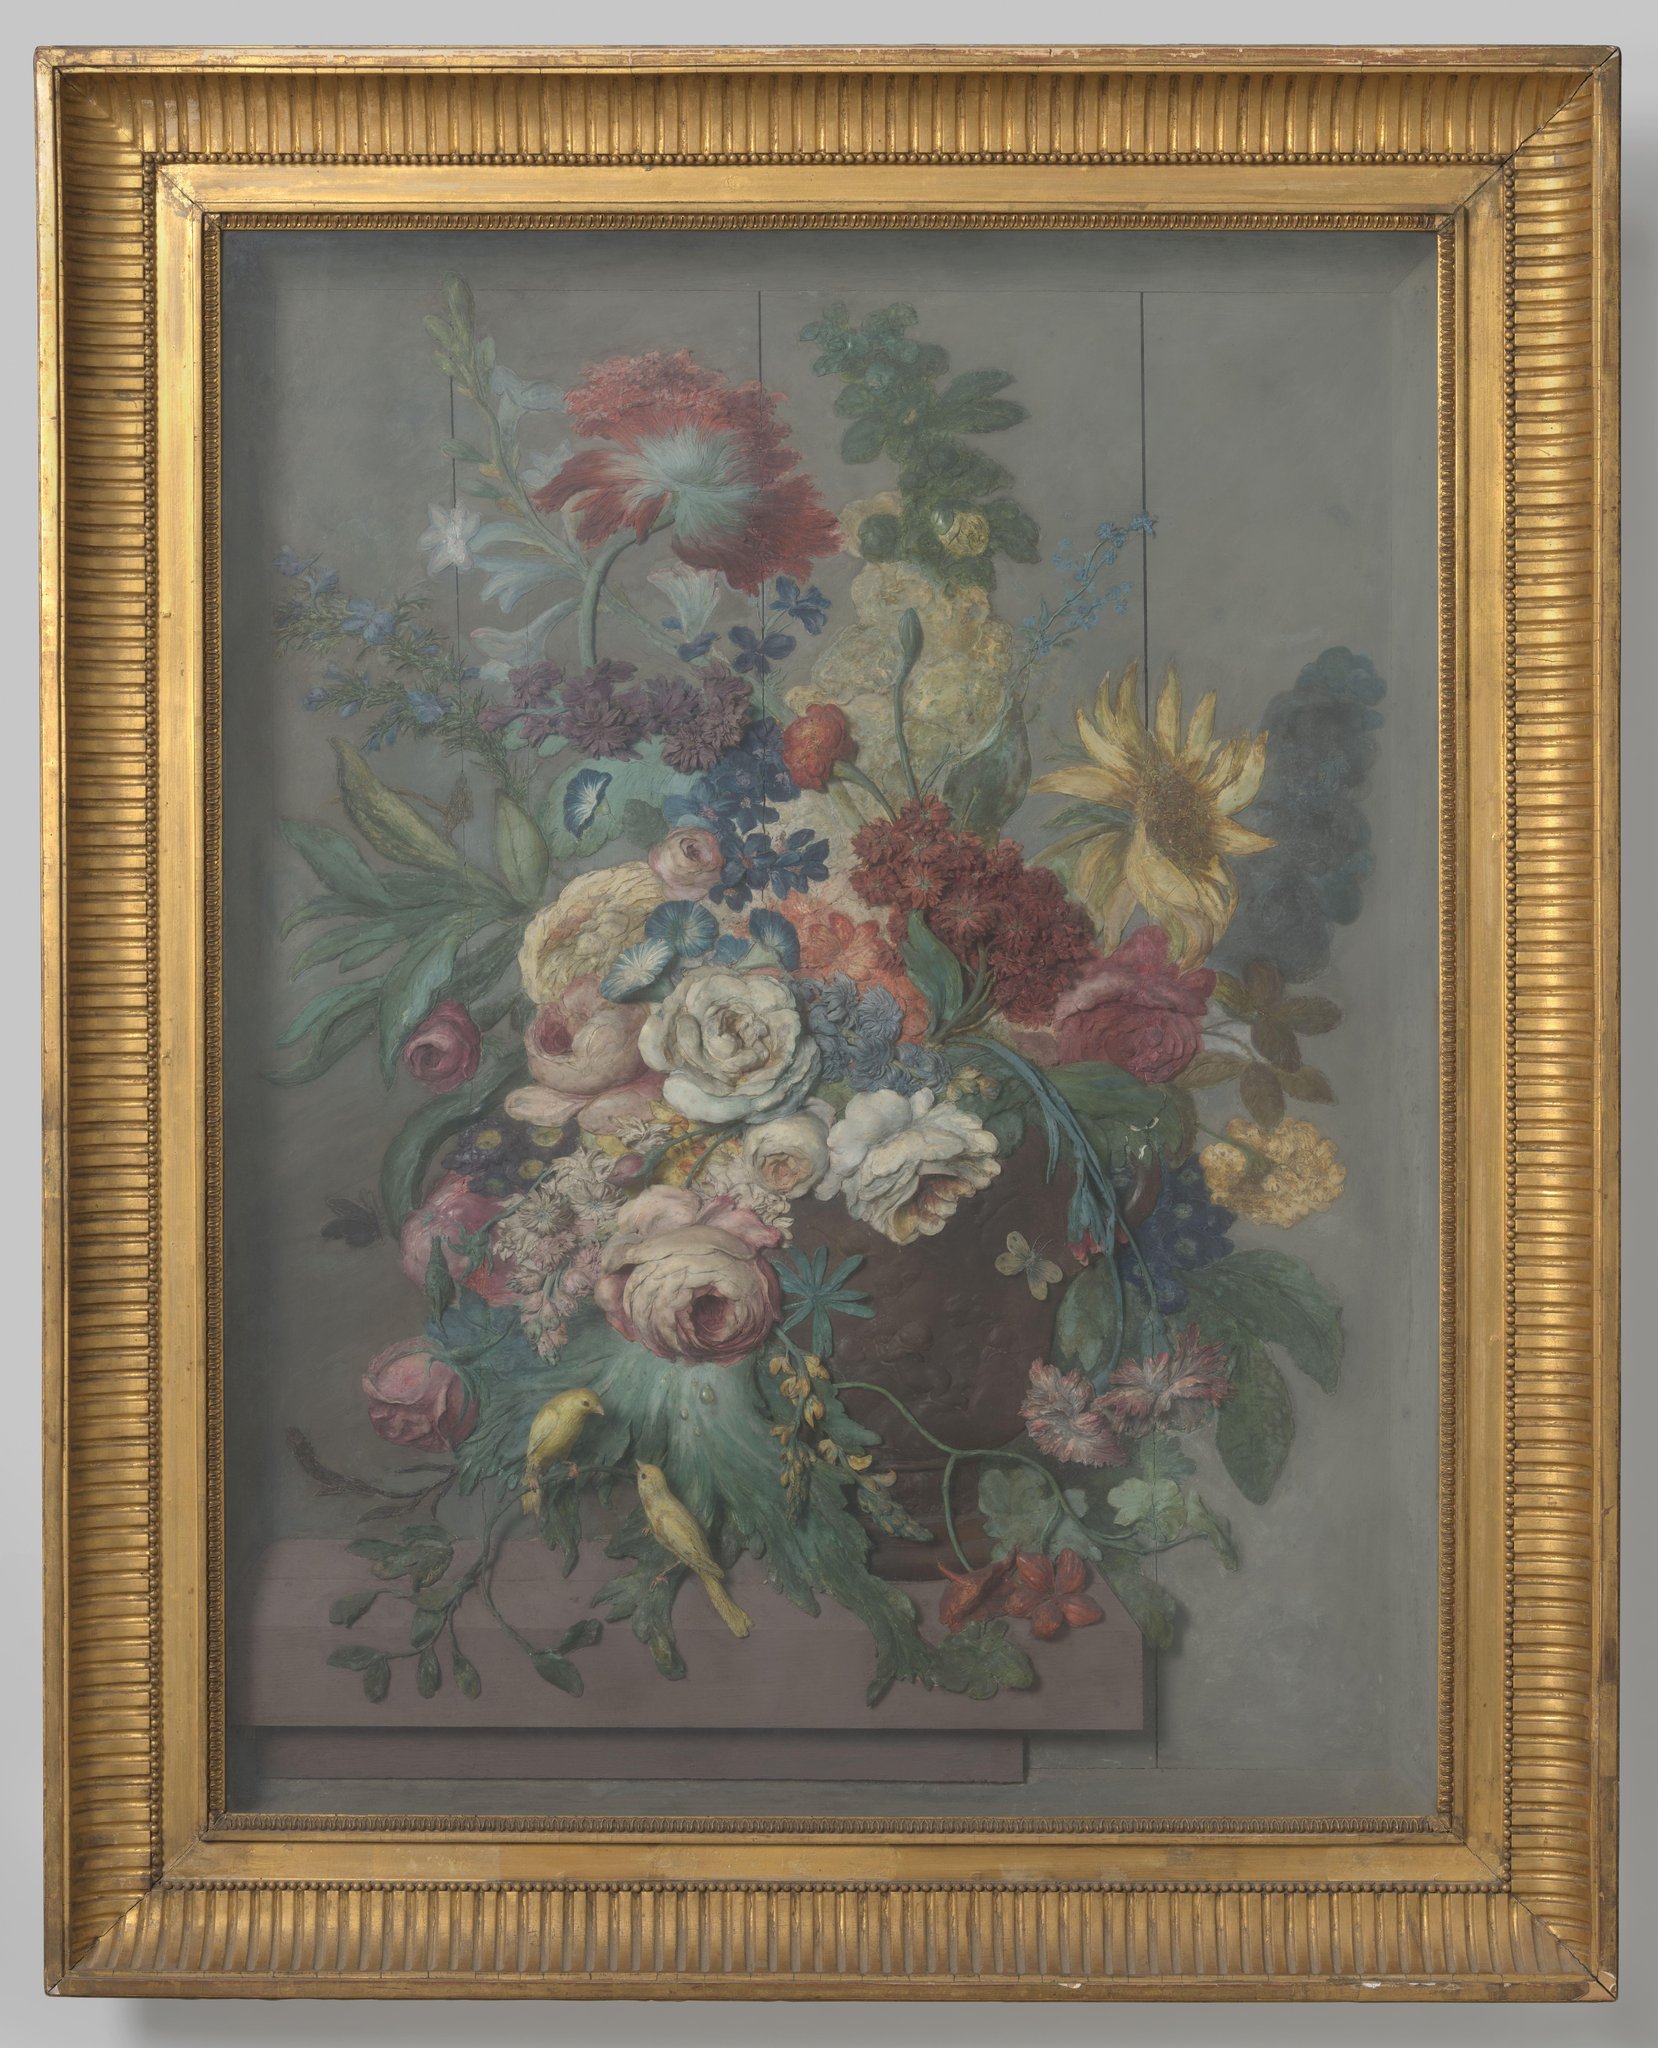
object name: relief sculpture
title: Vaas met bloemen en vruchten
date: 1400-1950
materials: wood